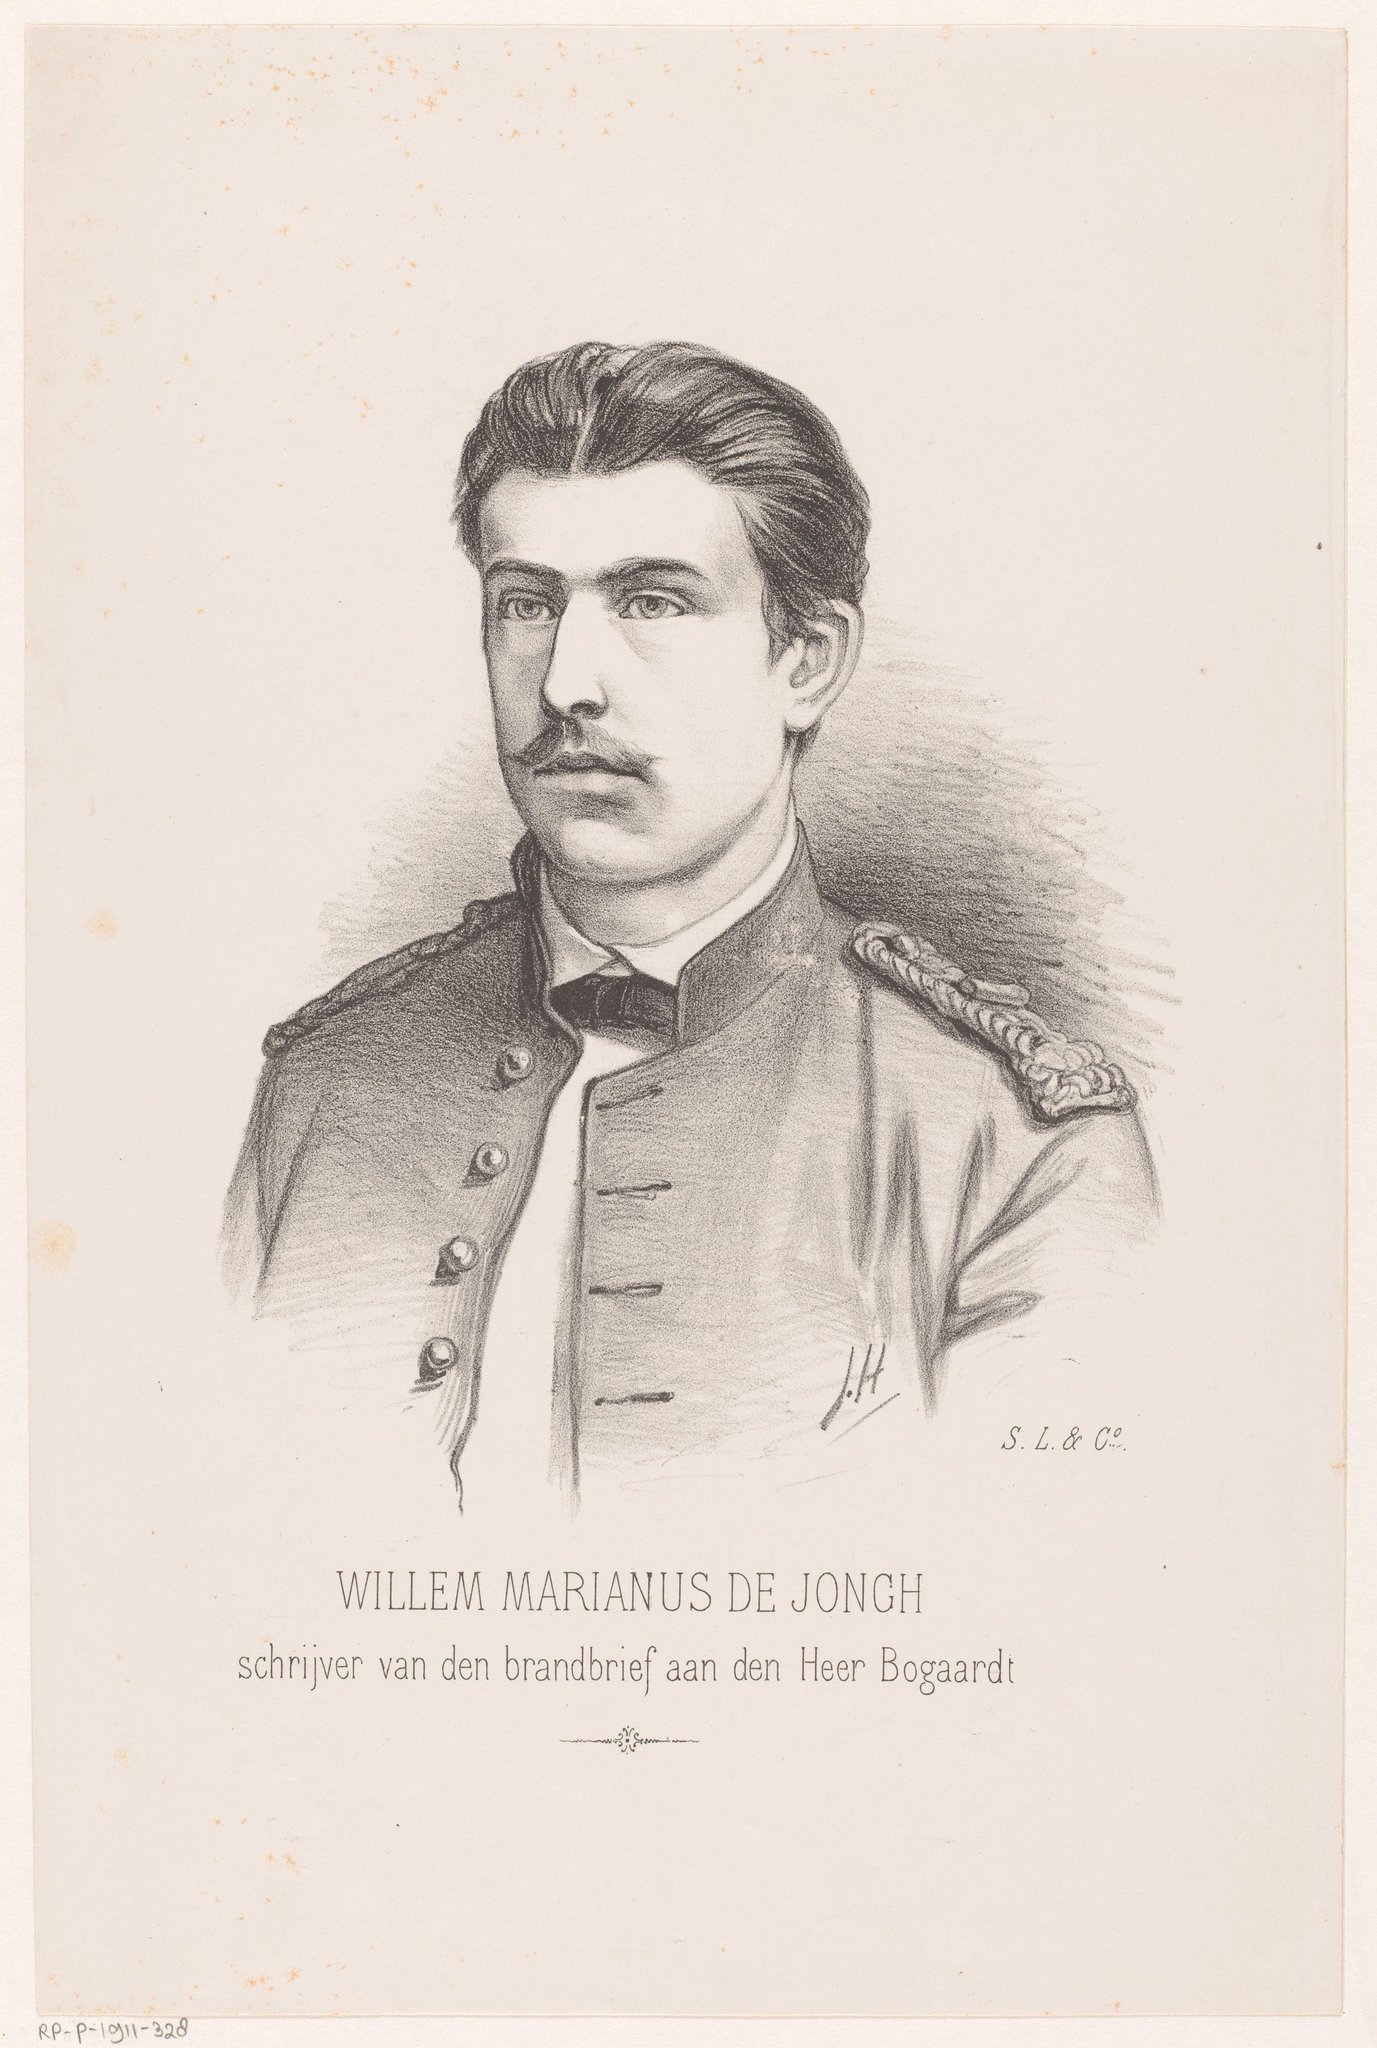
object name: print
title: Portret van Willem Marianus de Jongh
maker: jan holswilder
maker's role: print maker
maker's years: 1850-1890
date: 1877-1890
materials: paper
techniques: lithograph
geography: netherlands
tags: historical persons (+ (full) bust portrait)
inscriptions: collector's mark: Lugt 2228